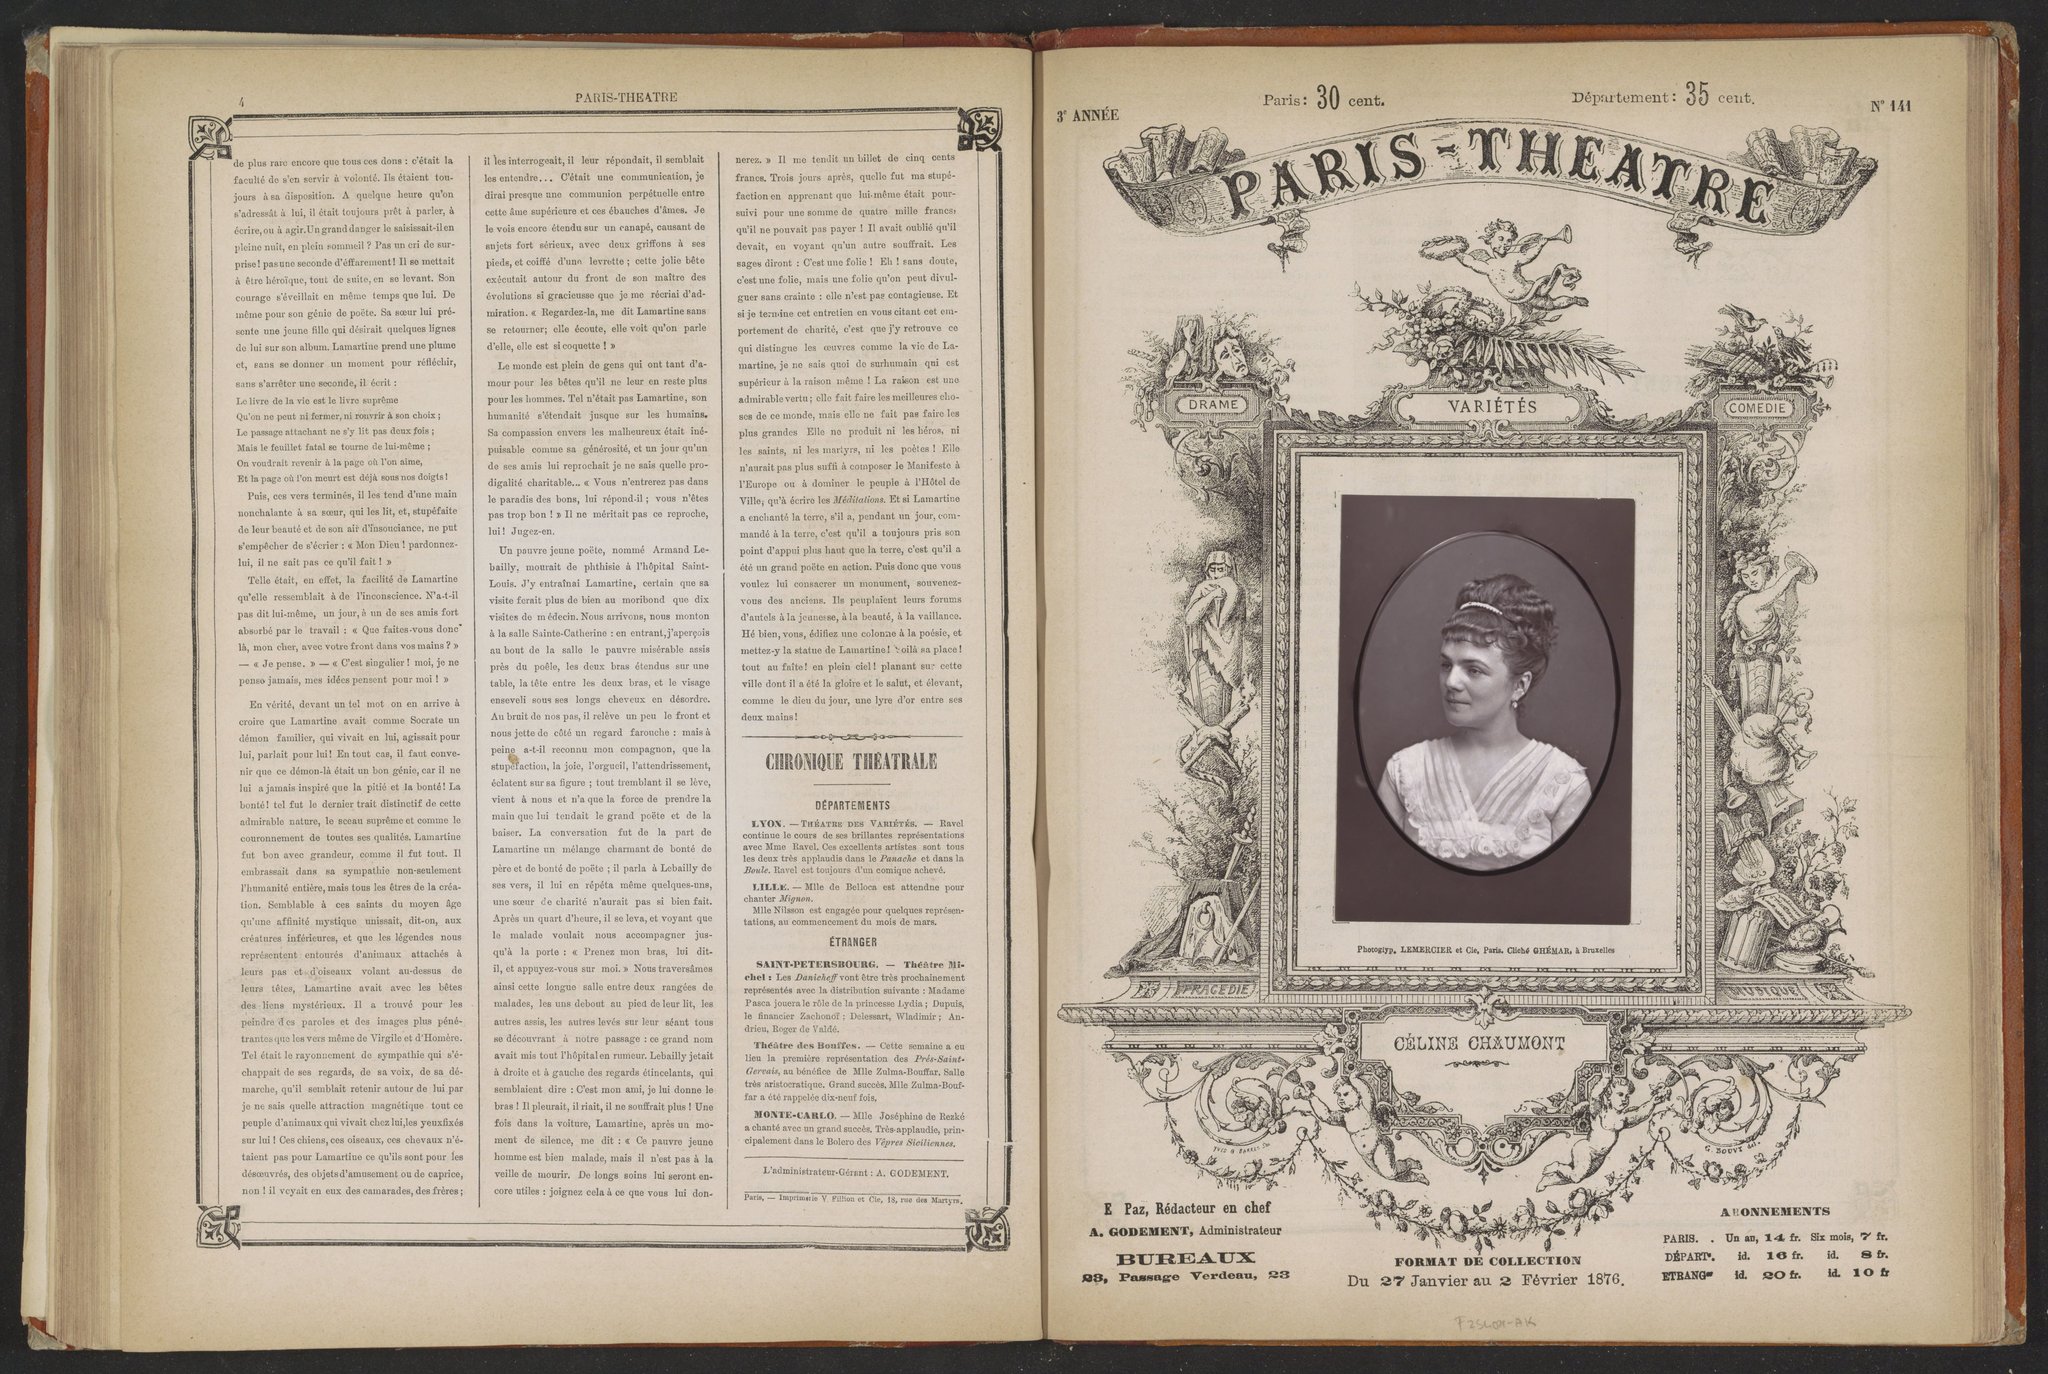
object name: page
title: Céline Chaumont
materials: paper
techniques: woodburytype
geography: brussels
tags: céline chaumont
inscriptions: number: ‘No 141’, number: ‘Du 27 Janvier au 2 Février 1876.’